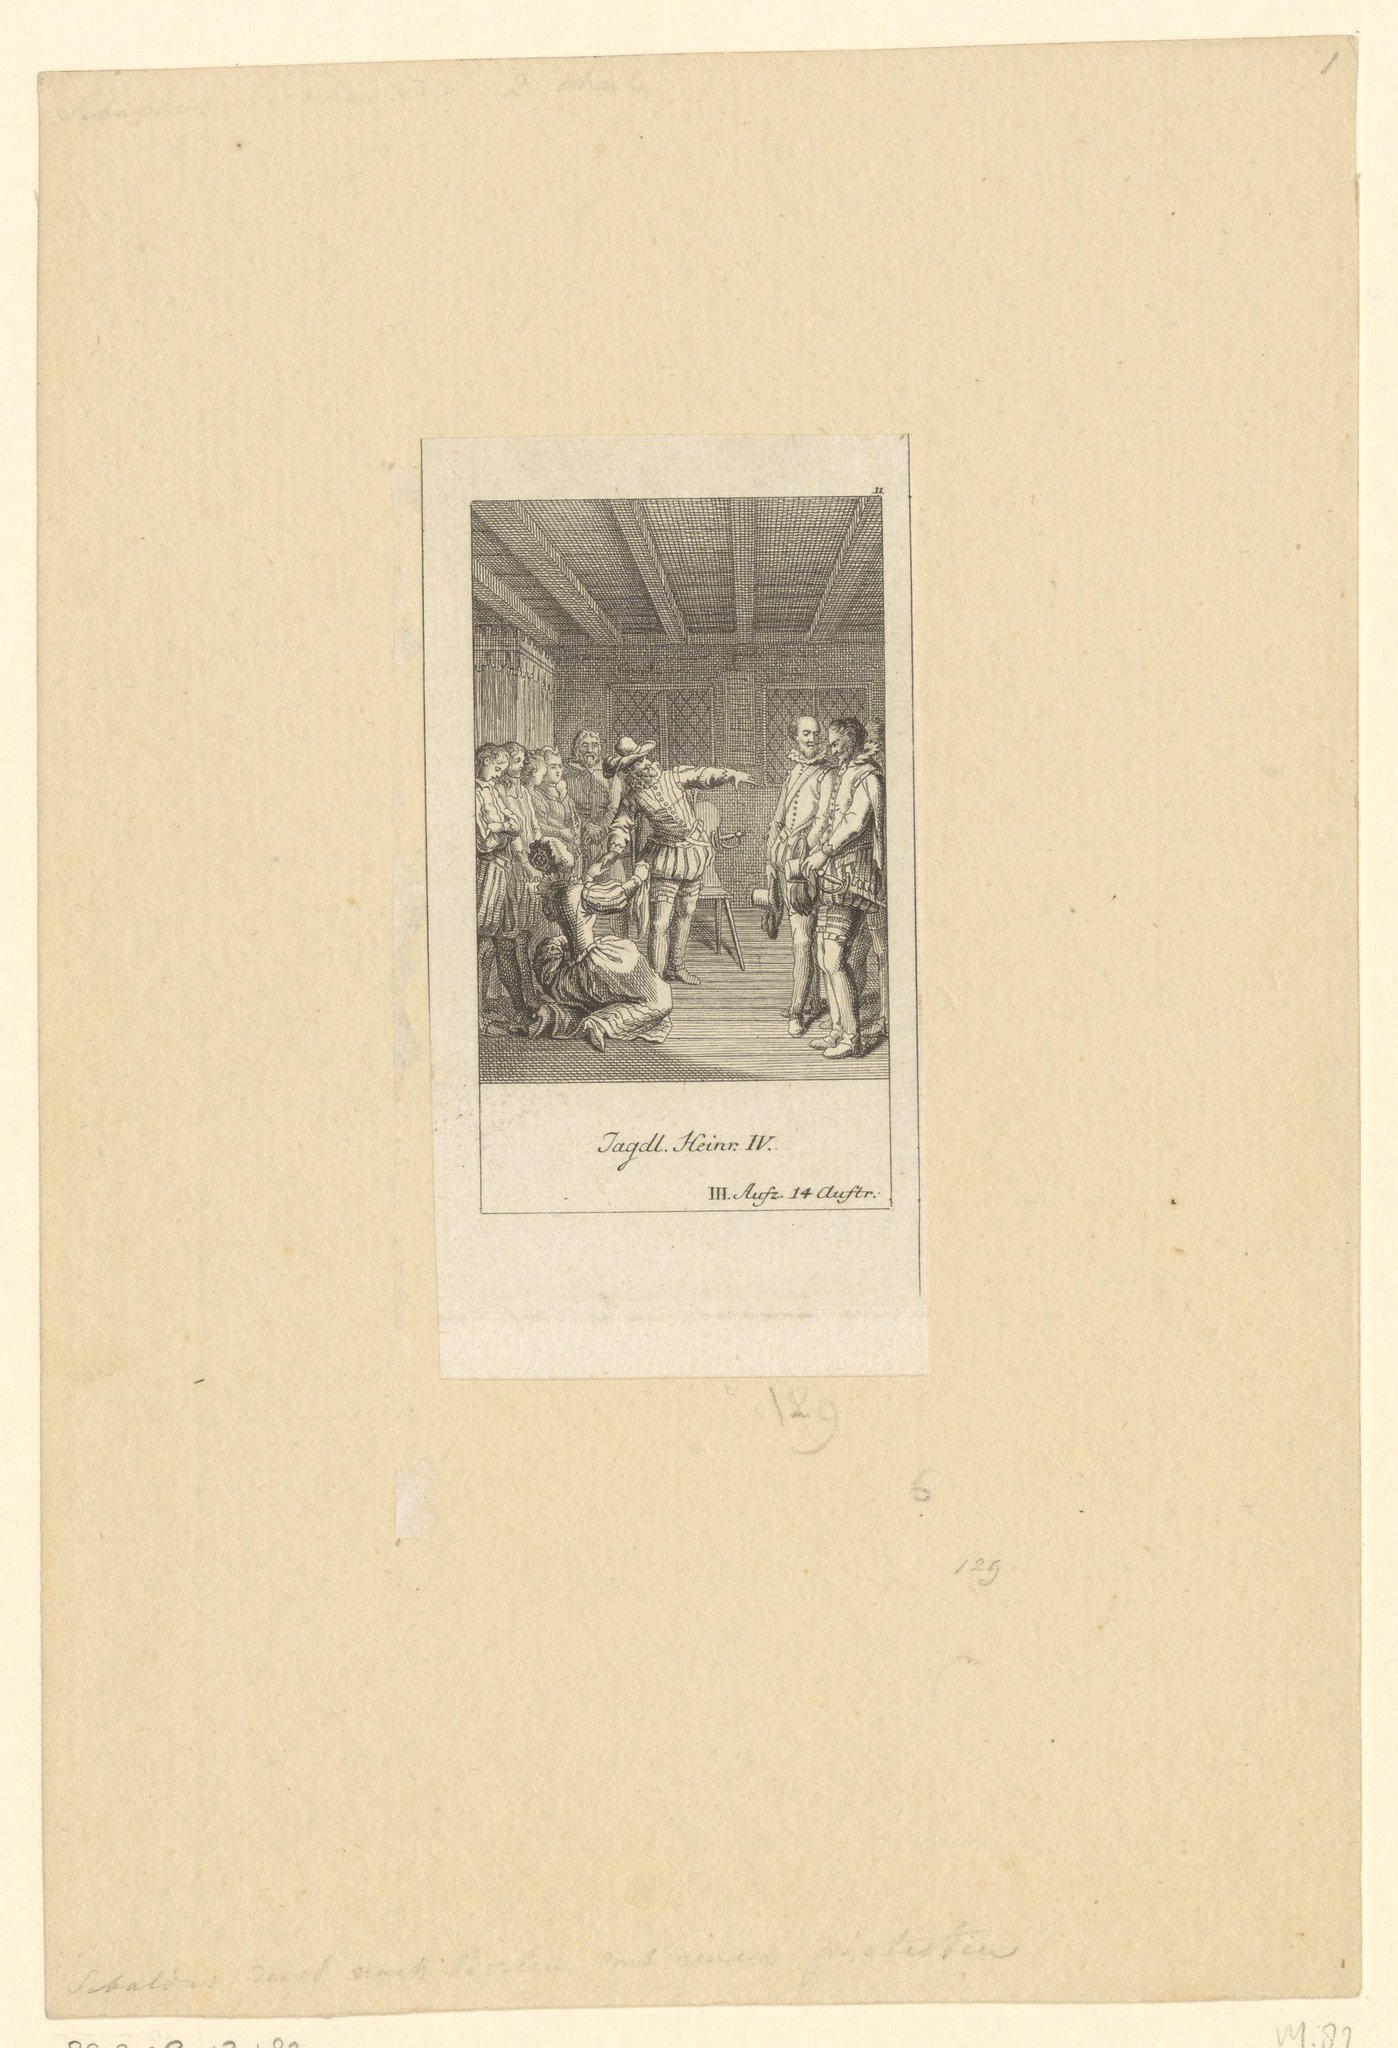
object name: book illustration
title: Agathe op haar knieën voor Hendrik IV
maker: daniel berger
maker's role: print maker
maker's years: 1744-1824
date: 1774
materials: paper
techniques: etching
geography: berlin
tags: paris, hendrik iv (koning van frankrijk en navarra), literary characters and objects, kneeling on both knees - aa - female human figure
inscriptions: collector's mark: Lugt 2228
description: Prent afkomstig uit: Genealogischen Calender für West-Preussen auf das Jahr 1775, uitgegeven op kosten van de Konigliche Academie der Wissenschaften. Deze prent maakt deel uit van een serie van twaalf prenten, gedrukt van een koperplaat. De prenten tonen scènes uit het toneelstuk 'La partie de chasse de Henri IV' (1767) van Charles Collé.